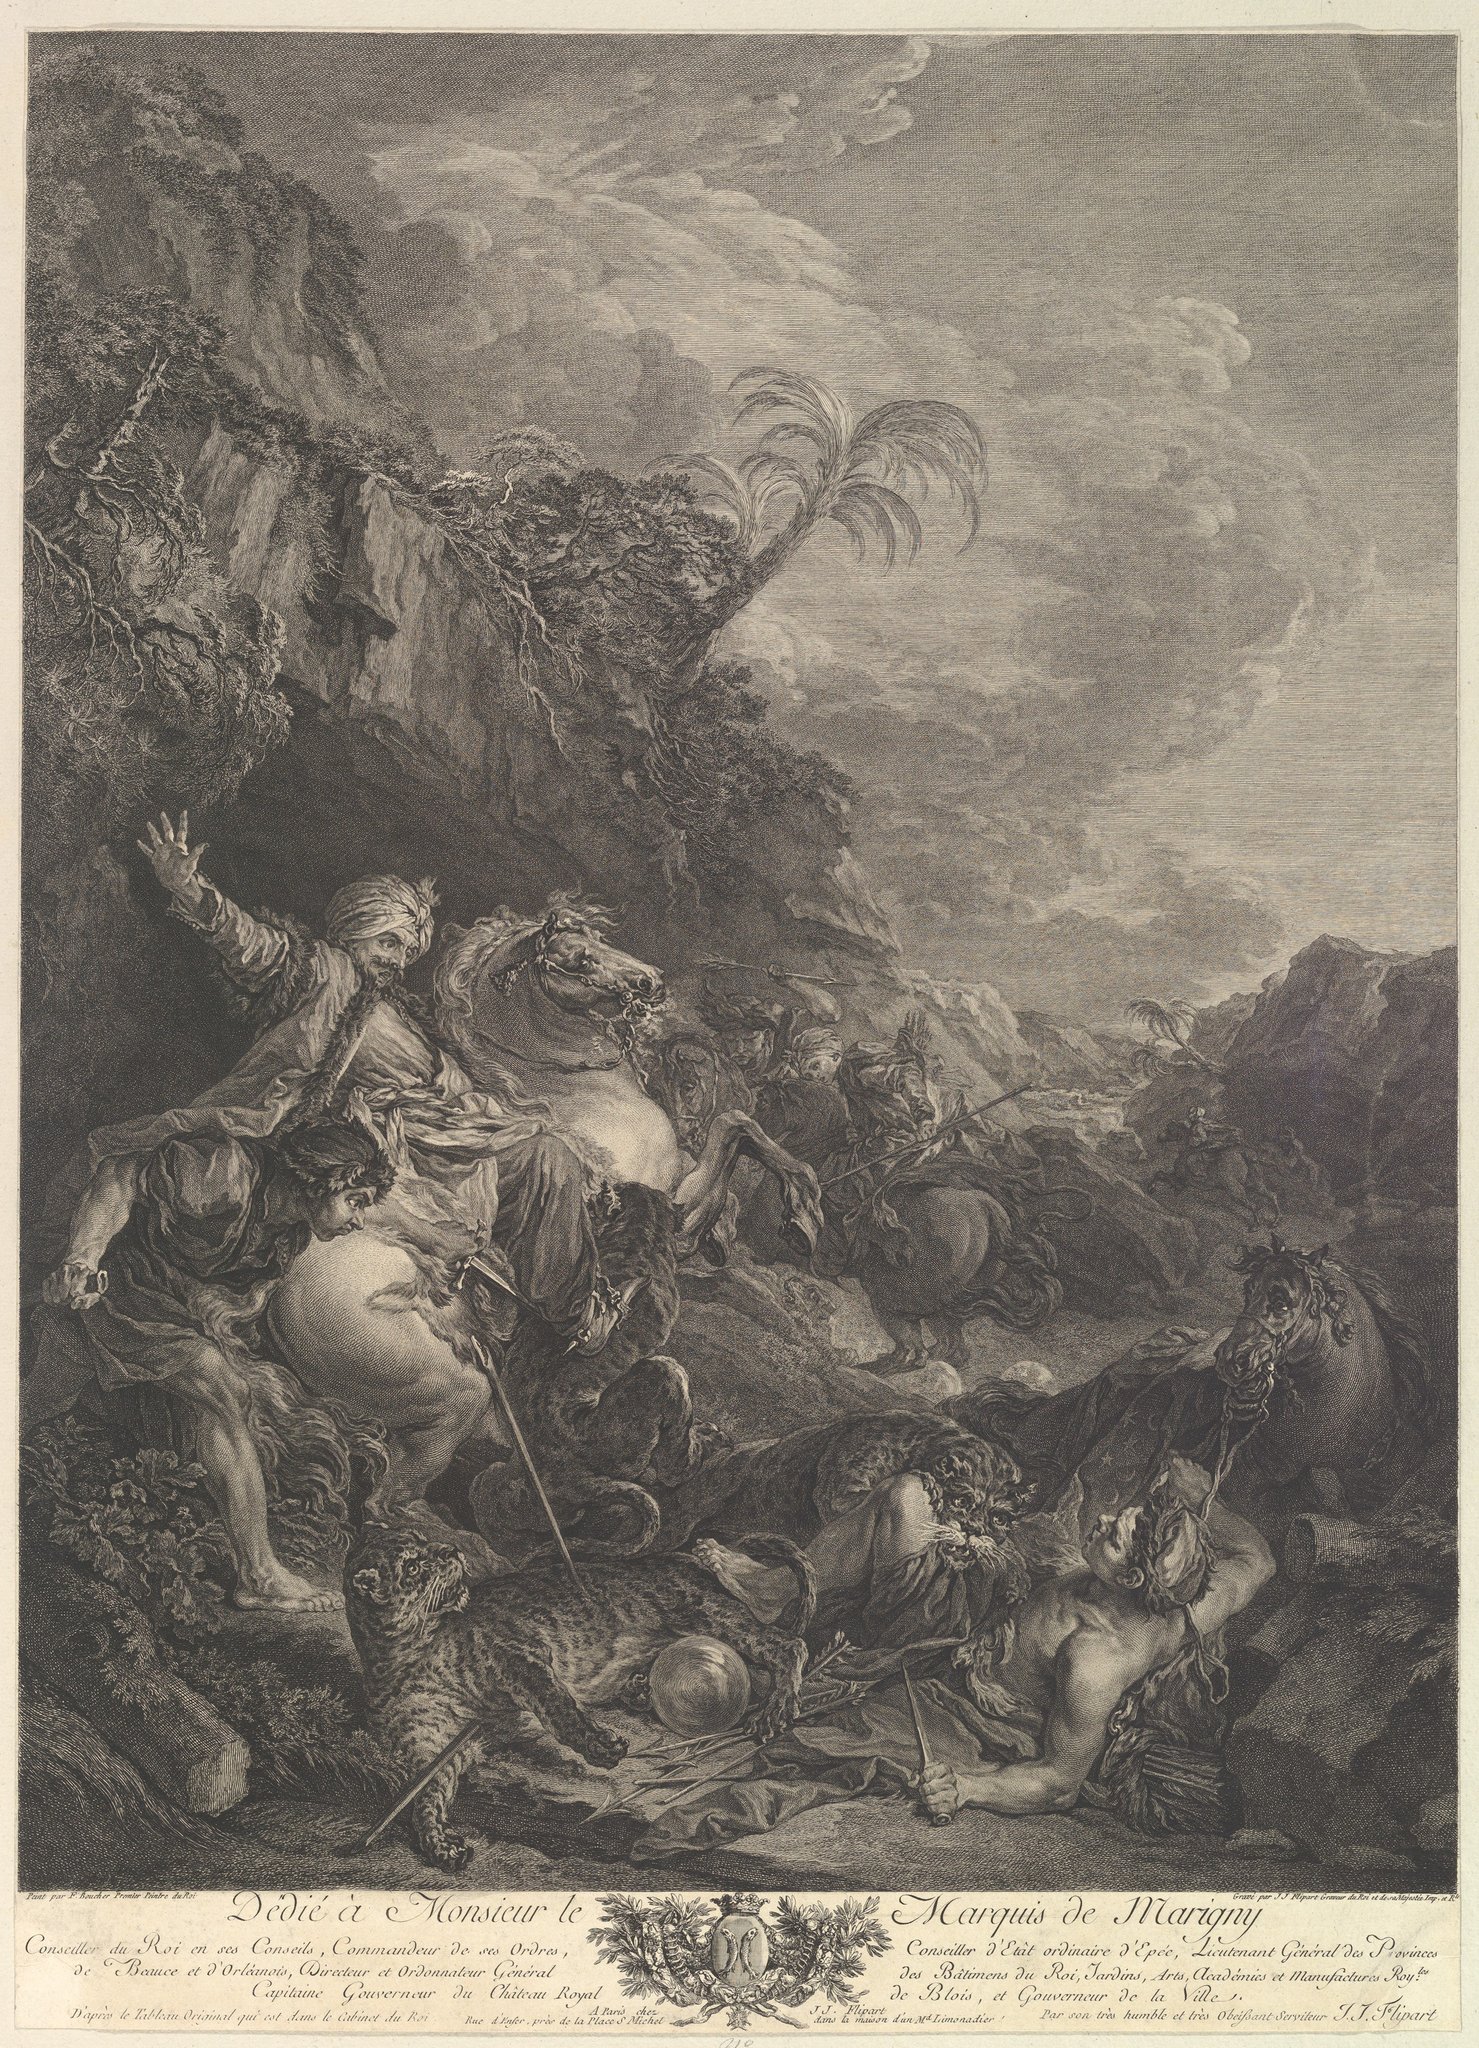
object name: print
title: La Chasse au Tigre (The Tiger Chase)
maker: jean jacques flipart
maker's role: artist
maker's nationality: french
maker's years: 1719-1782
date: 1701-1800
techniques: drypoint, engraving, etching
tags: men,horses,tigers